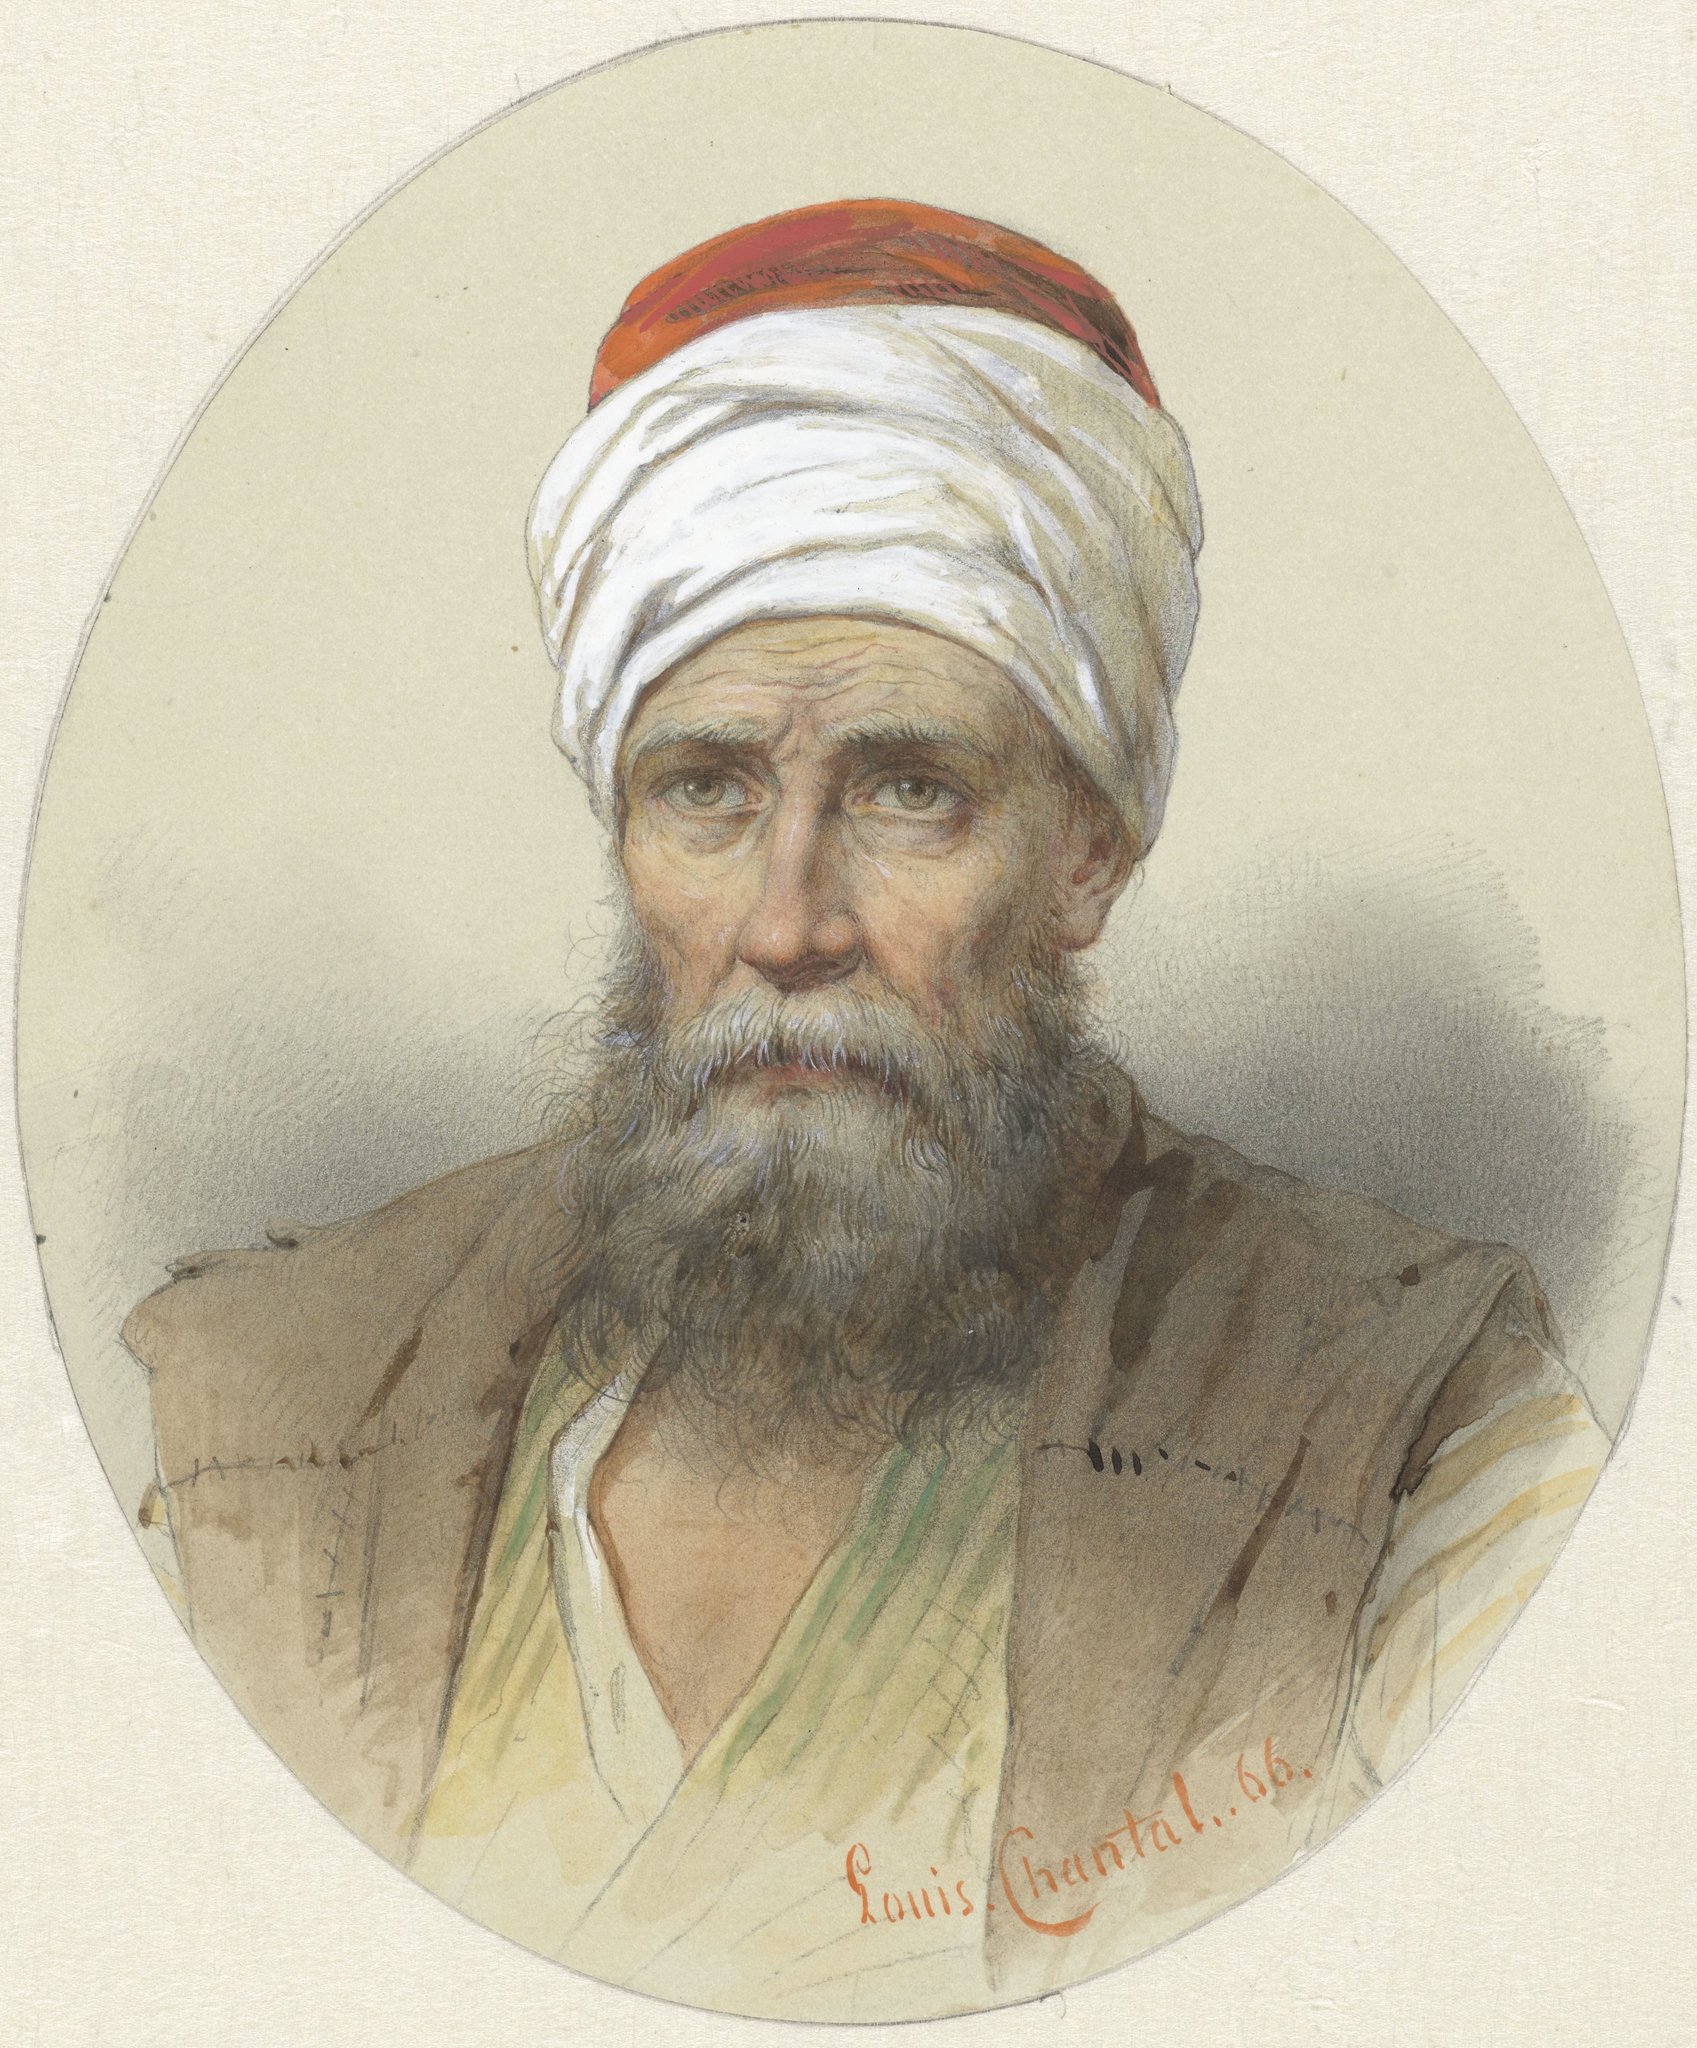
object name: drawing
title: Man met tulband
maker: louis chantal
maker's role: draughtsman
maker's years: 1822-1899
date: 1866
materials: paint, paper, pencil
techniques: brush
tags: asiatic races and peoples (with name)